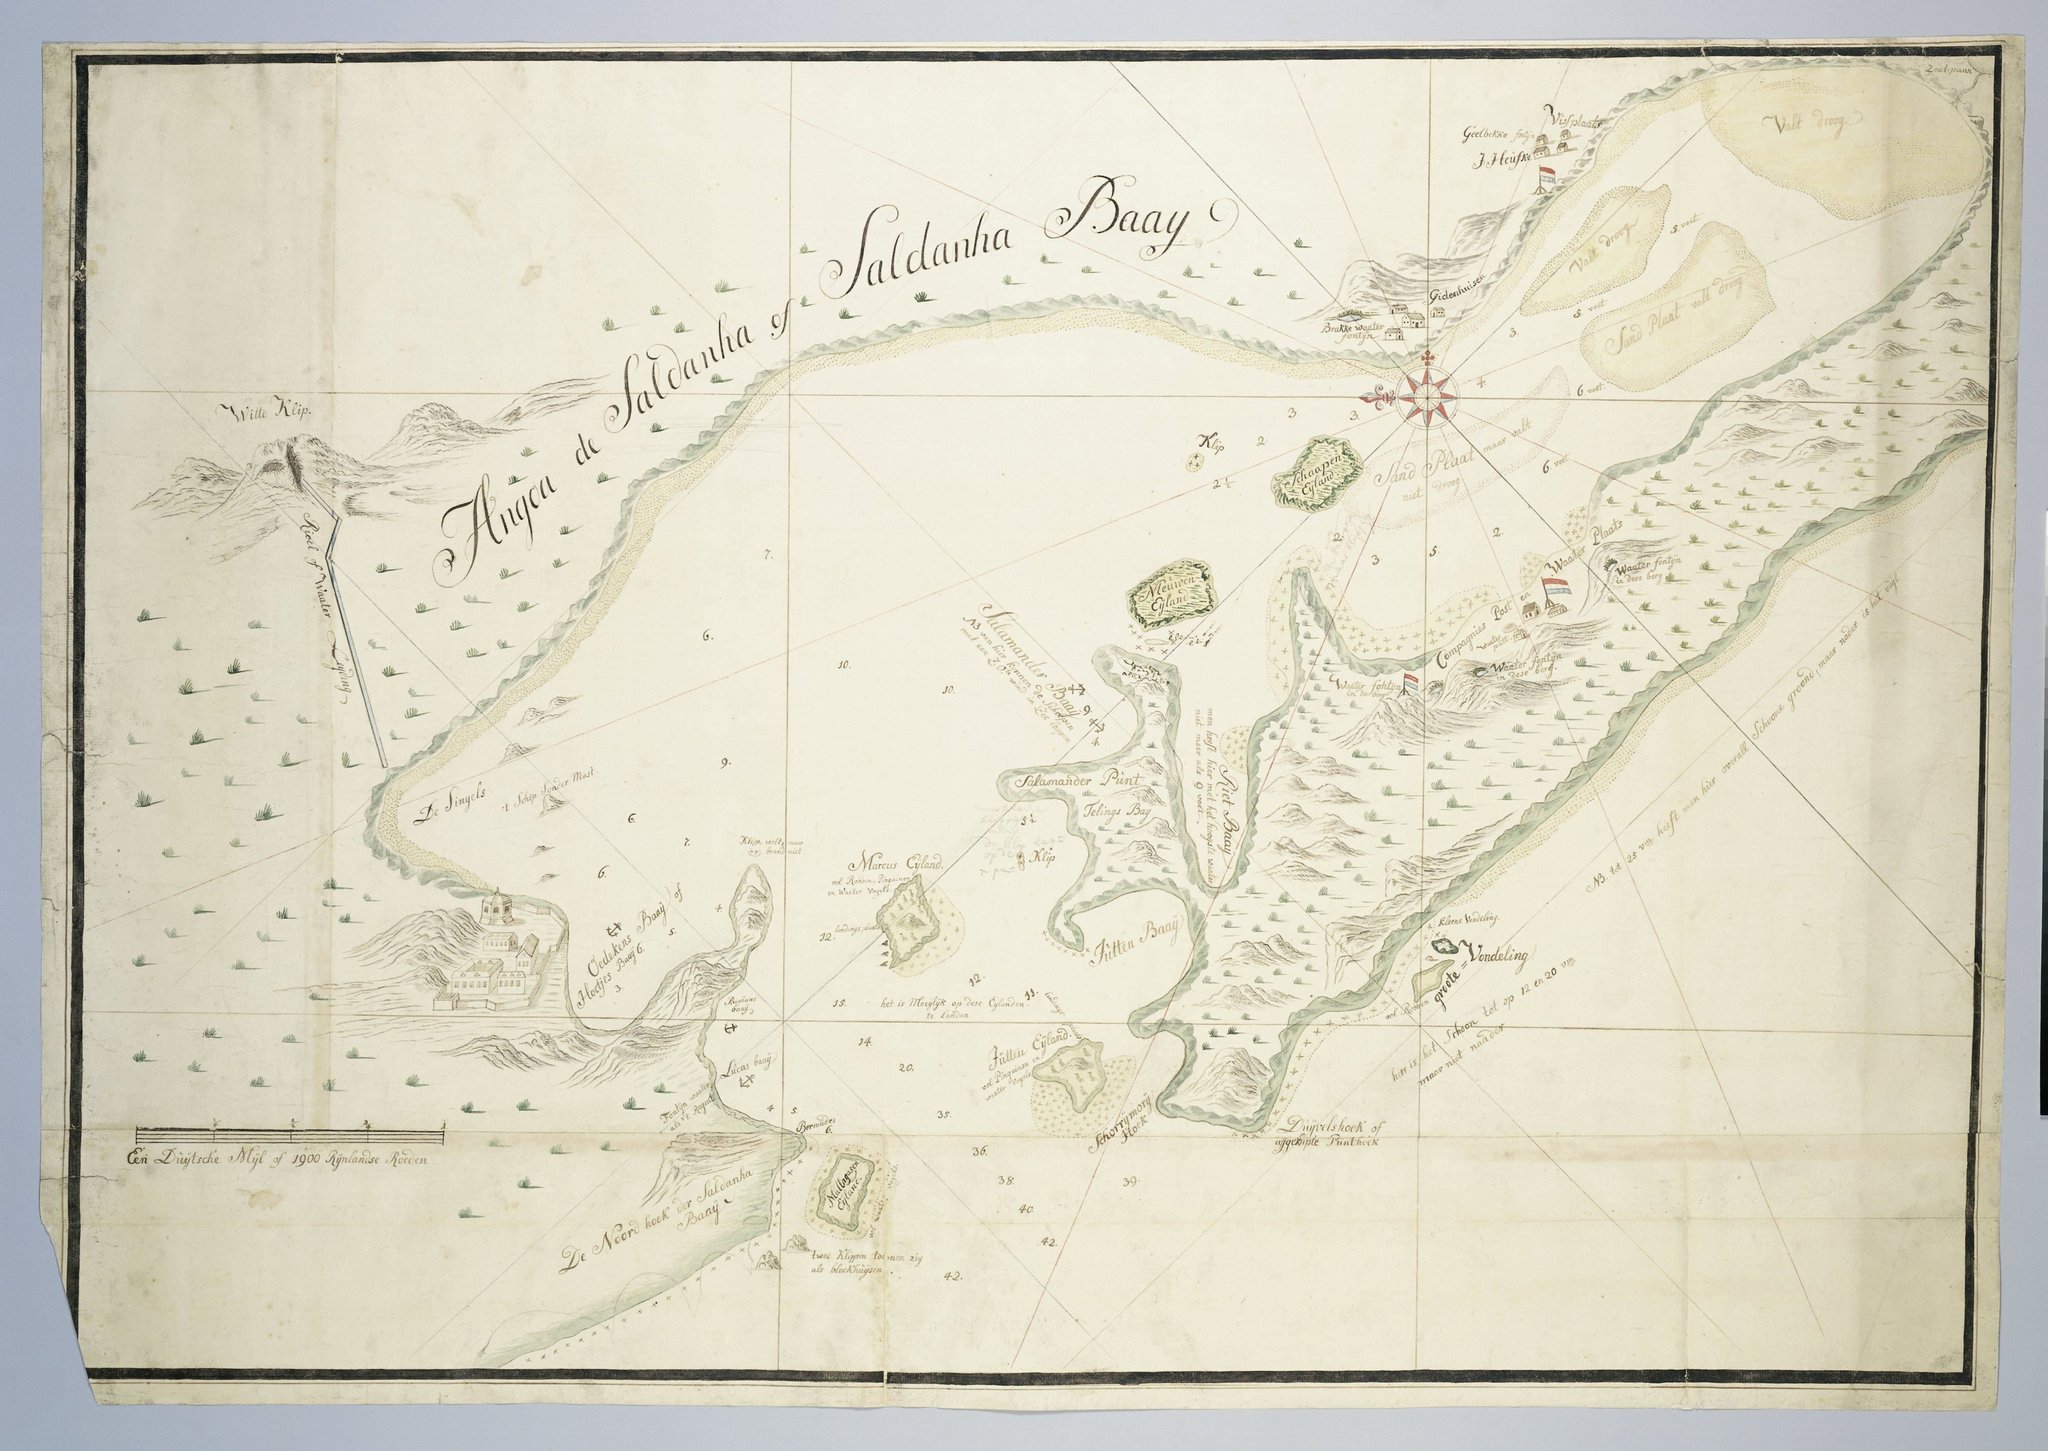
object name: drawing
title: Map of Saldanha Bay and immediate surroundings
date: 1784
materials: ink, paper, pencil, watercolor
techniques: brush, pen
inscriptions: annotation: ‘zie De Jong’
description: Ontsloten door middel van 9 afgebakende delen, aangeduid door de letters A t/m J (met gidskaart, voorzien van kompasroos met streken).